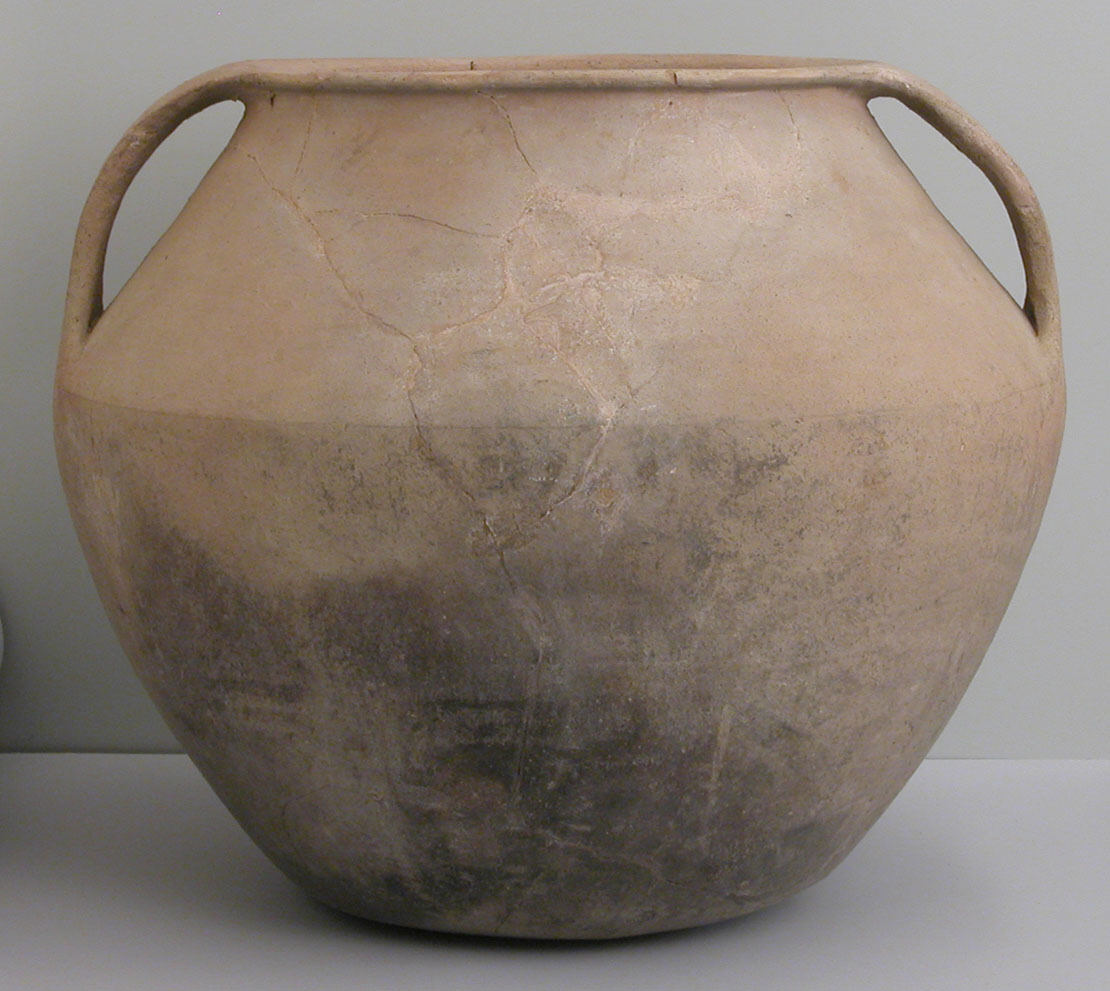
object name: jar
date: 701-900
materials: earthenware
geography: iran